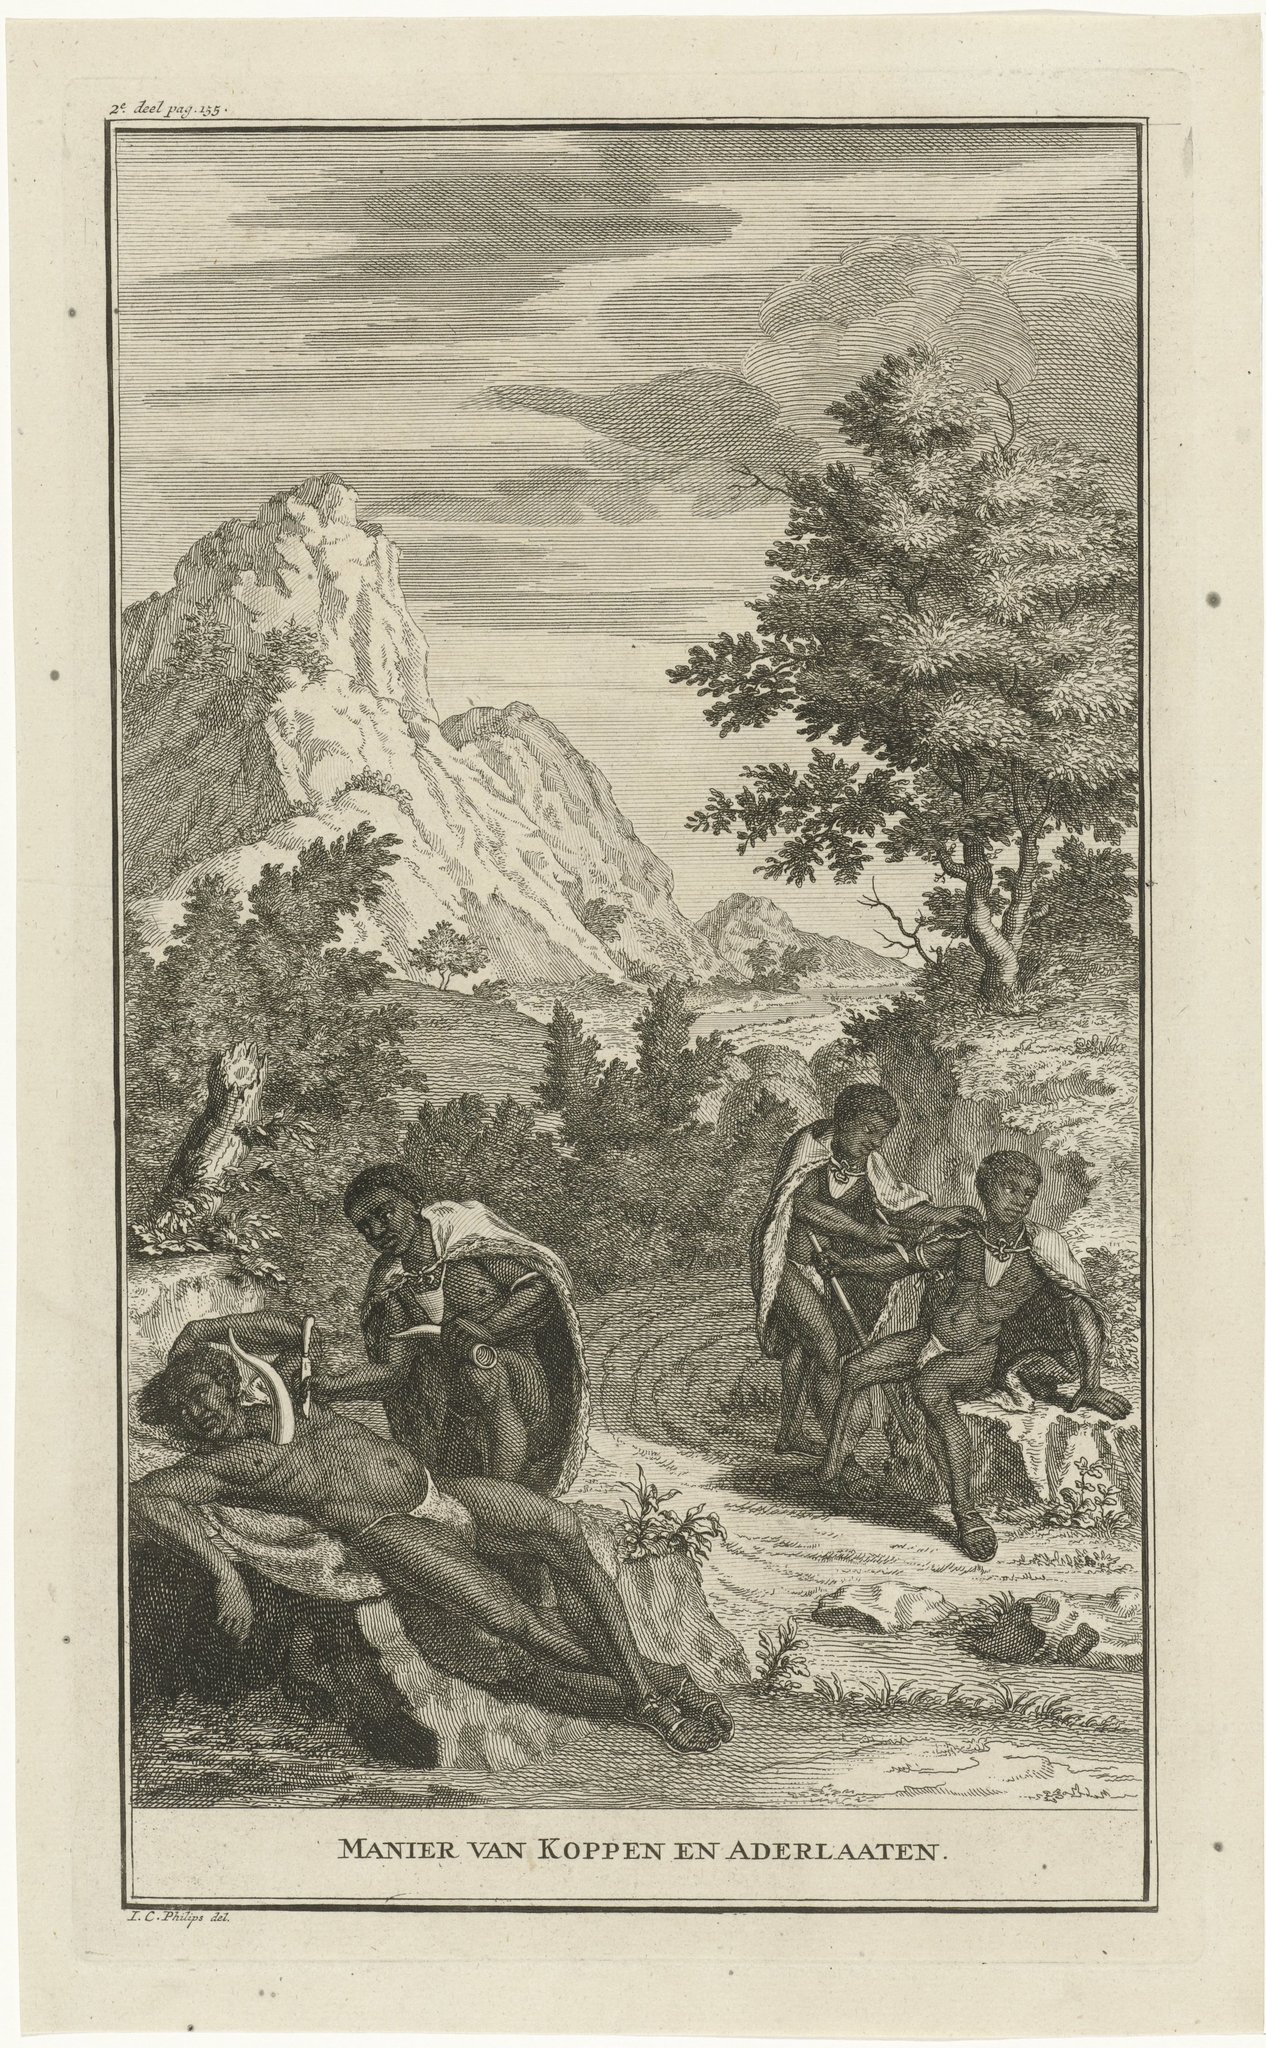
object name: book illustration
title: Koppen en aderlaten door Khoikhoi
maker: jan caspar philips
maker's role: draughtsman, print maker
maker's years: 1700-1775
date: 1727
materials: paper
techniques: engraving, etching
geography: amsterdam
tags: cupping man (~ bleeding, blood-letting), khoikhoi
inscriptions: collector's mark: Lugt 2228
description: Landschap met Khoikhoi die bij patiënten koppen zetten en aderlaten. Op de voorgrond ligt een man, met een hoorn op de pijnlijke plek om de wond te verdoven. De dokter snijdt in het lichaam, zet de hoorn er weer op, die zich vervolgens vol bloed zuigt. Op de achtergrond het aderlaten bij een patiënt met een riem en een mes.